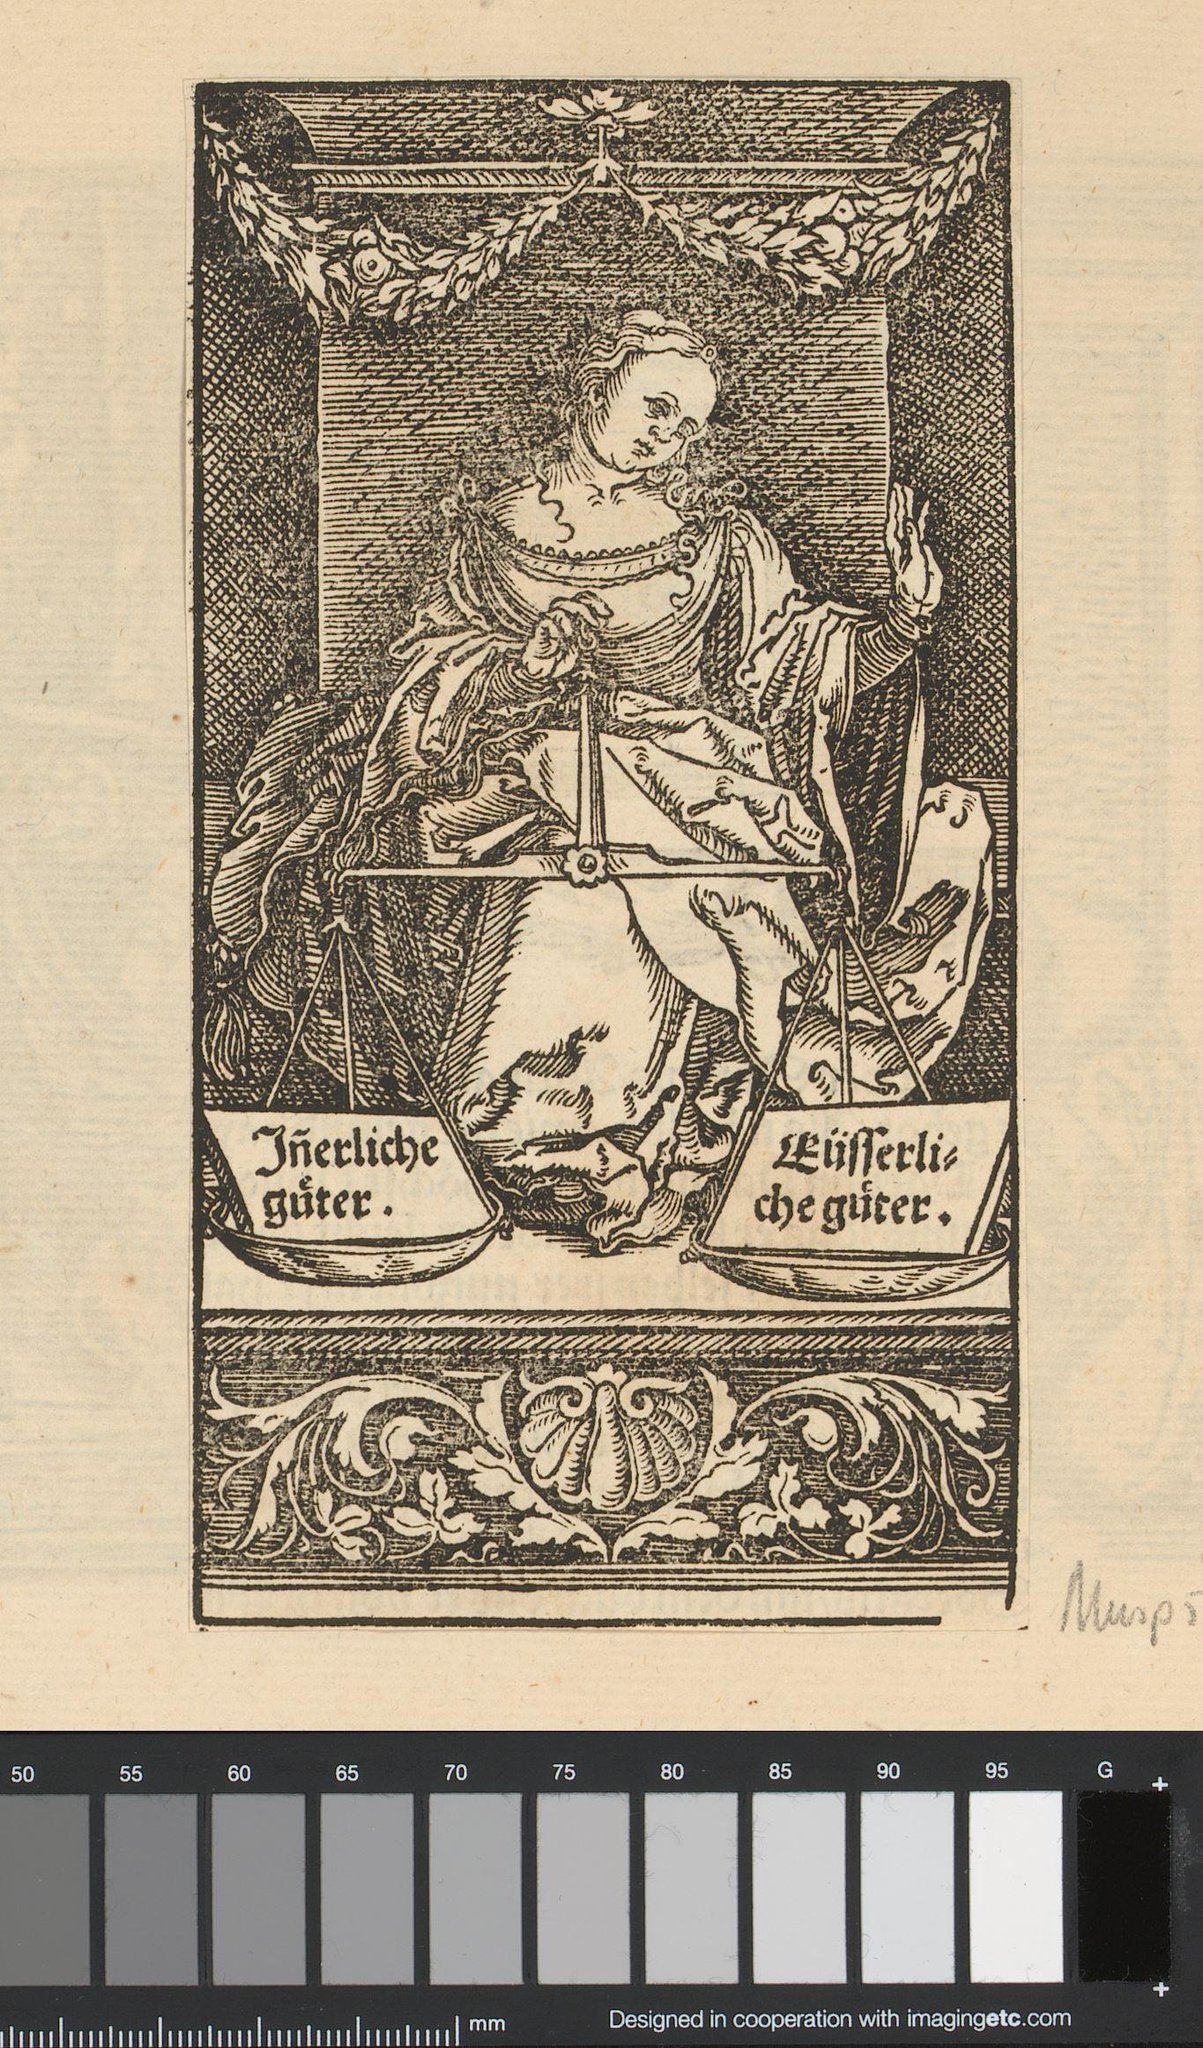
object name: print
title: Vrouw weegt het innerlijke tegen het uiterlijke af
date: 1514-1531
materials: paper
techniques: letterpress printing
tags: balance, equilibrium (+ symbolical representation of concept), judgment of conduct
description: Deze prent is gebruikt in: Cicero, Marcus Tulius. Officia M.T.C. Ein Buch so Marcus Tullius Cicero der Römer zu seynem (...). [Vertaald uit het Latijn door] Johann von Schwarzenberg. Augsburg: Heinrich Steiner, 1531.